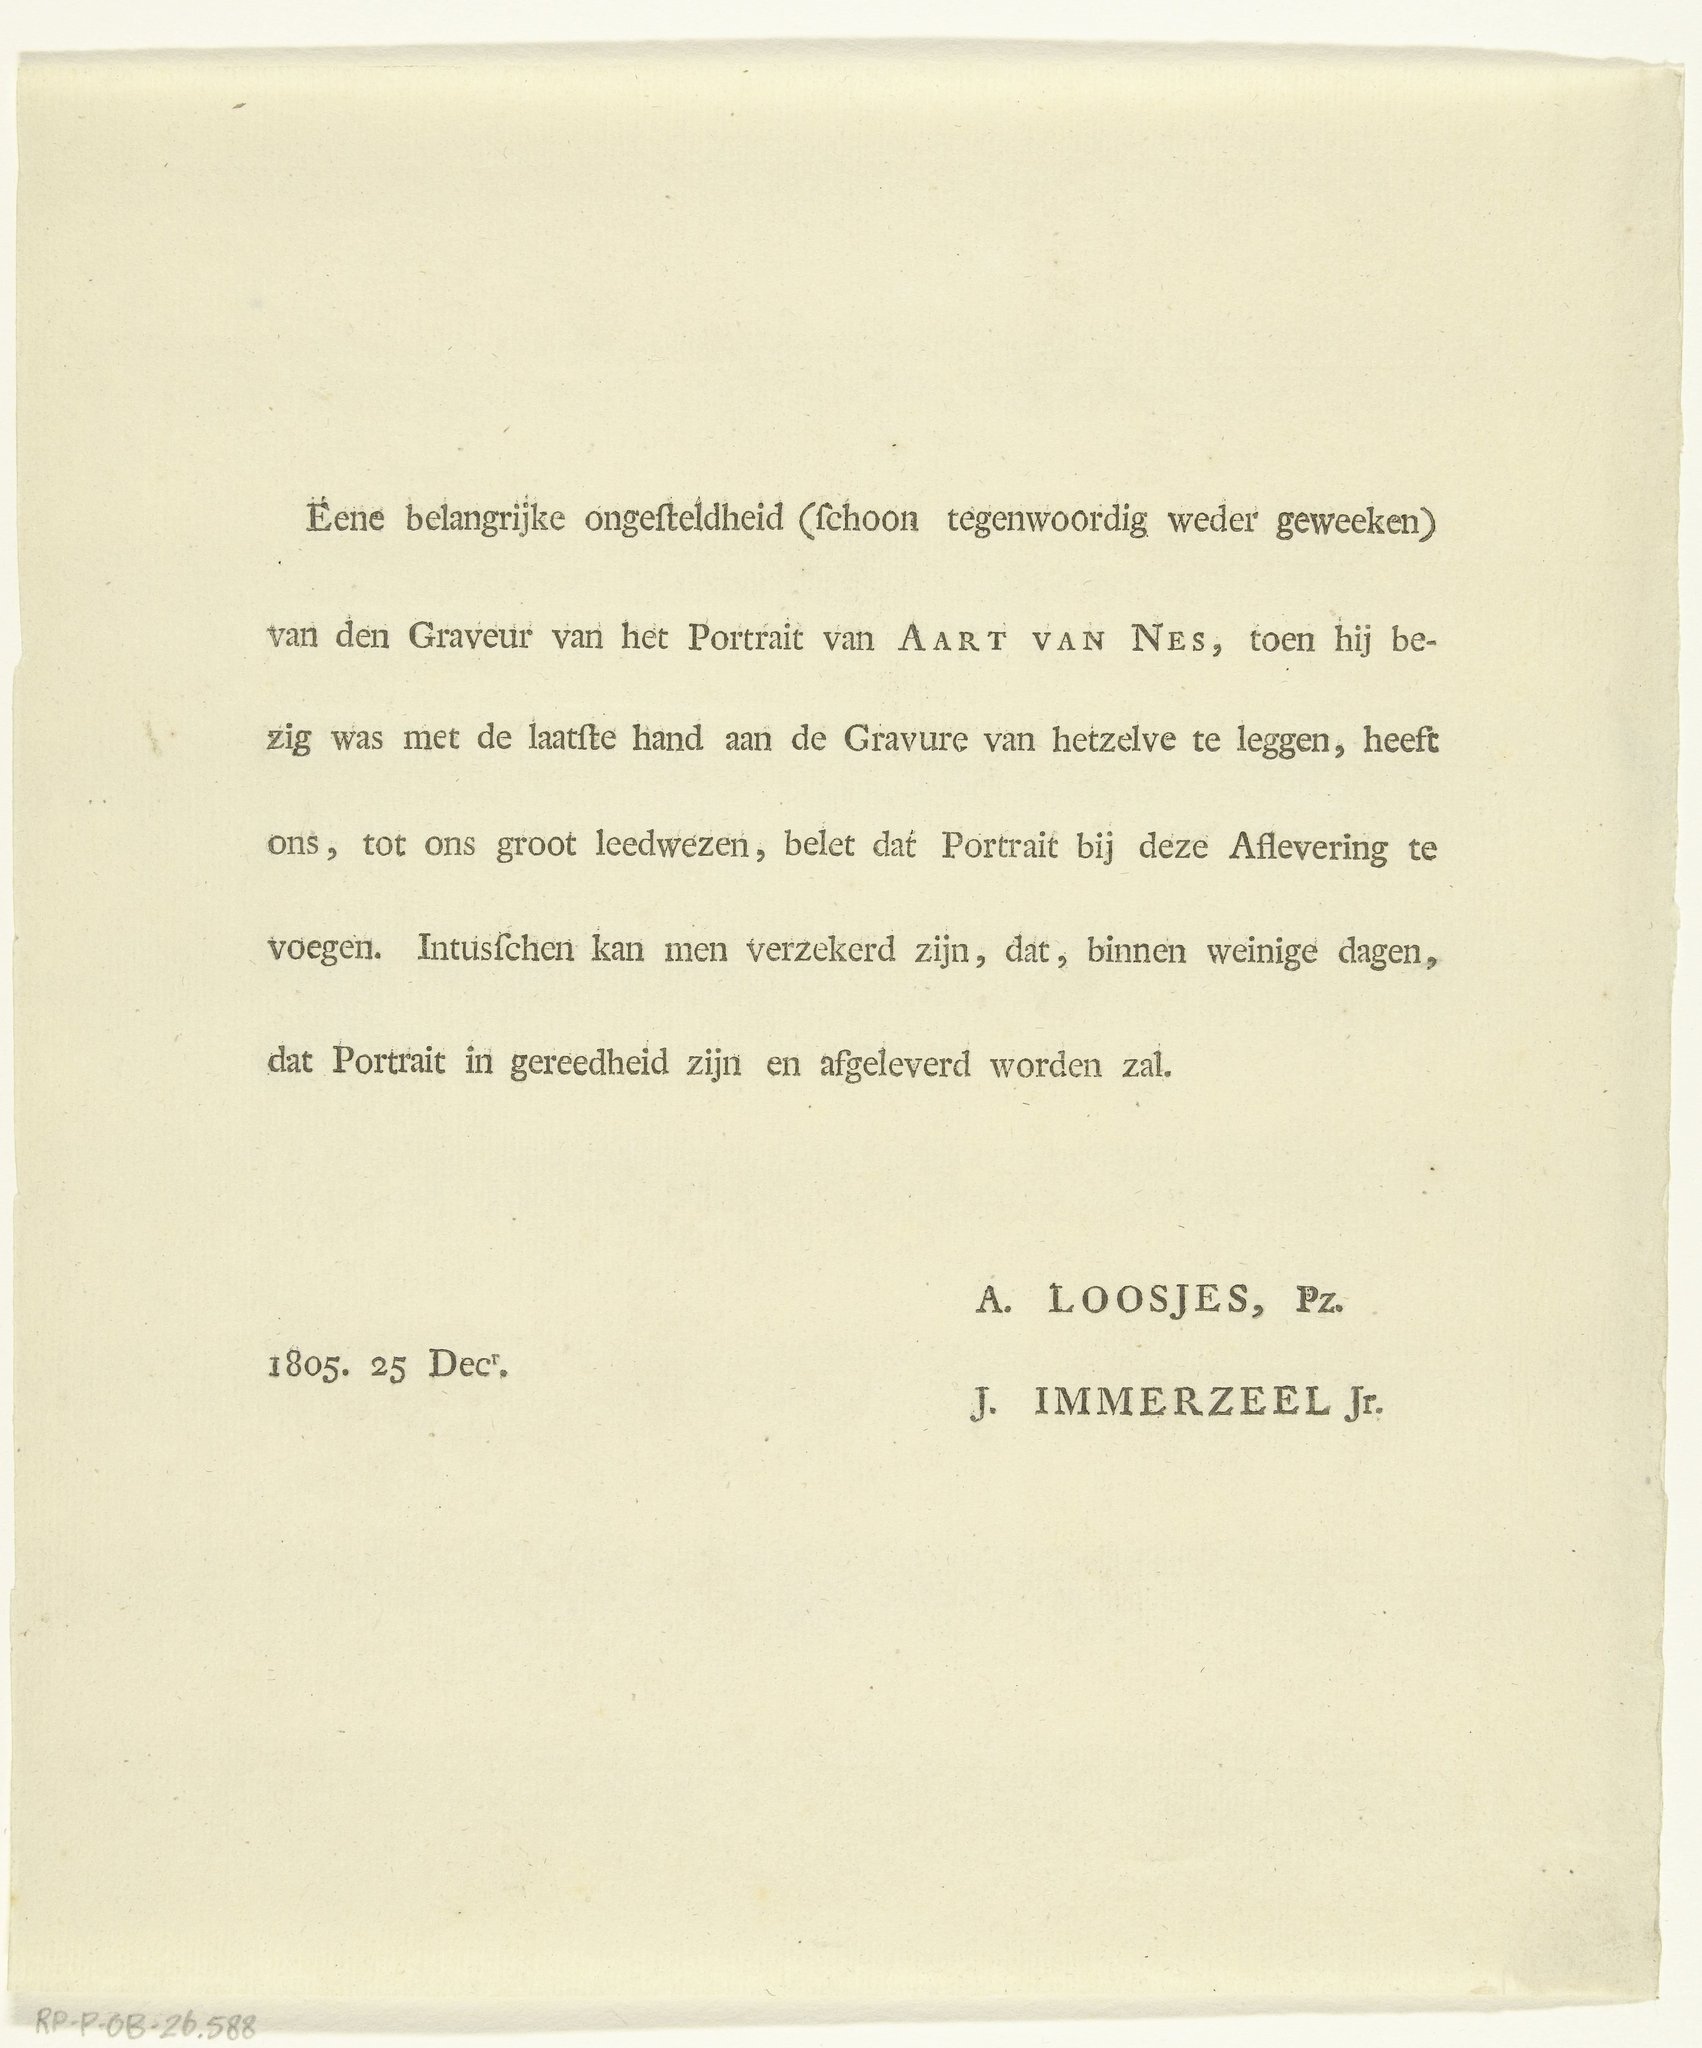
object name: print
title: Tekst bij portret van marineofficier Aert Jansz. van Nes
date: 1805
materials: paper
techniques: letterpress printing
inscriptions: date